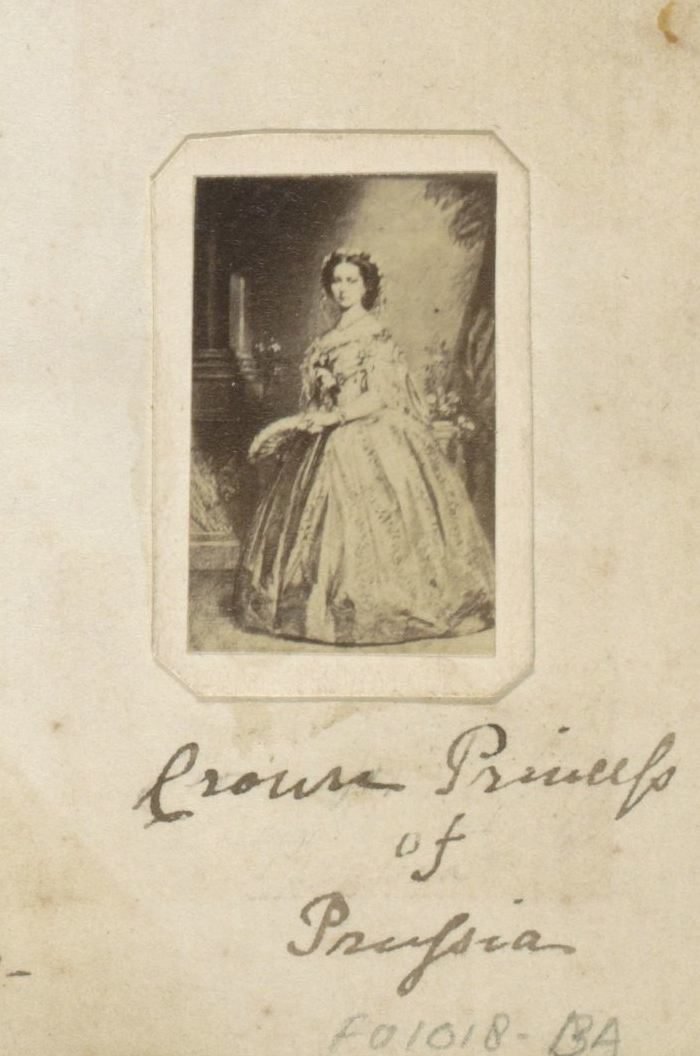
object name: photograph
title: Crown Princess of Prussia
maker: Anonymous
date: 1860-1870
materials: cardboard, paper, photographic support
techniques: albumen print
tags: koning, frederik iii (koning van pruisen en duits keizer)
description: Onderdeel van Engels familiealbum met foto's van personen, reizen, cricket en kunstwerken.